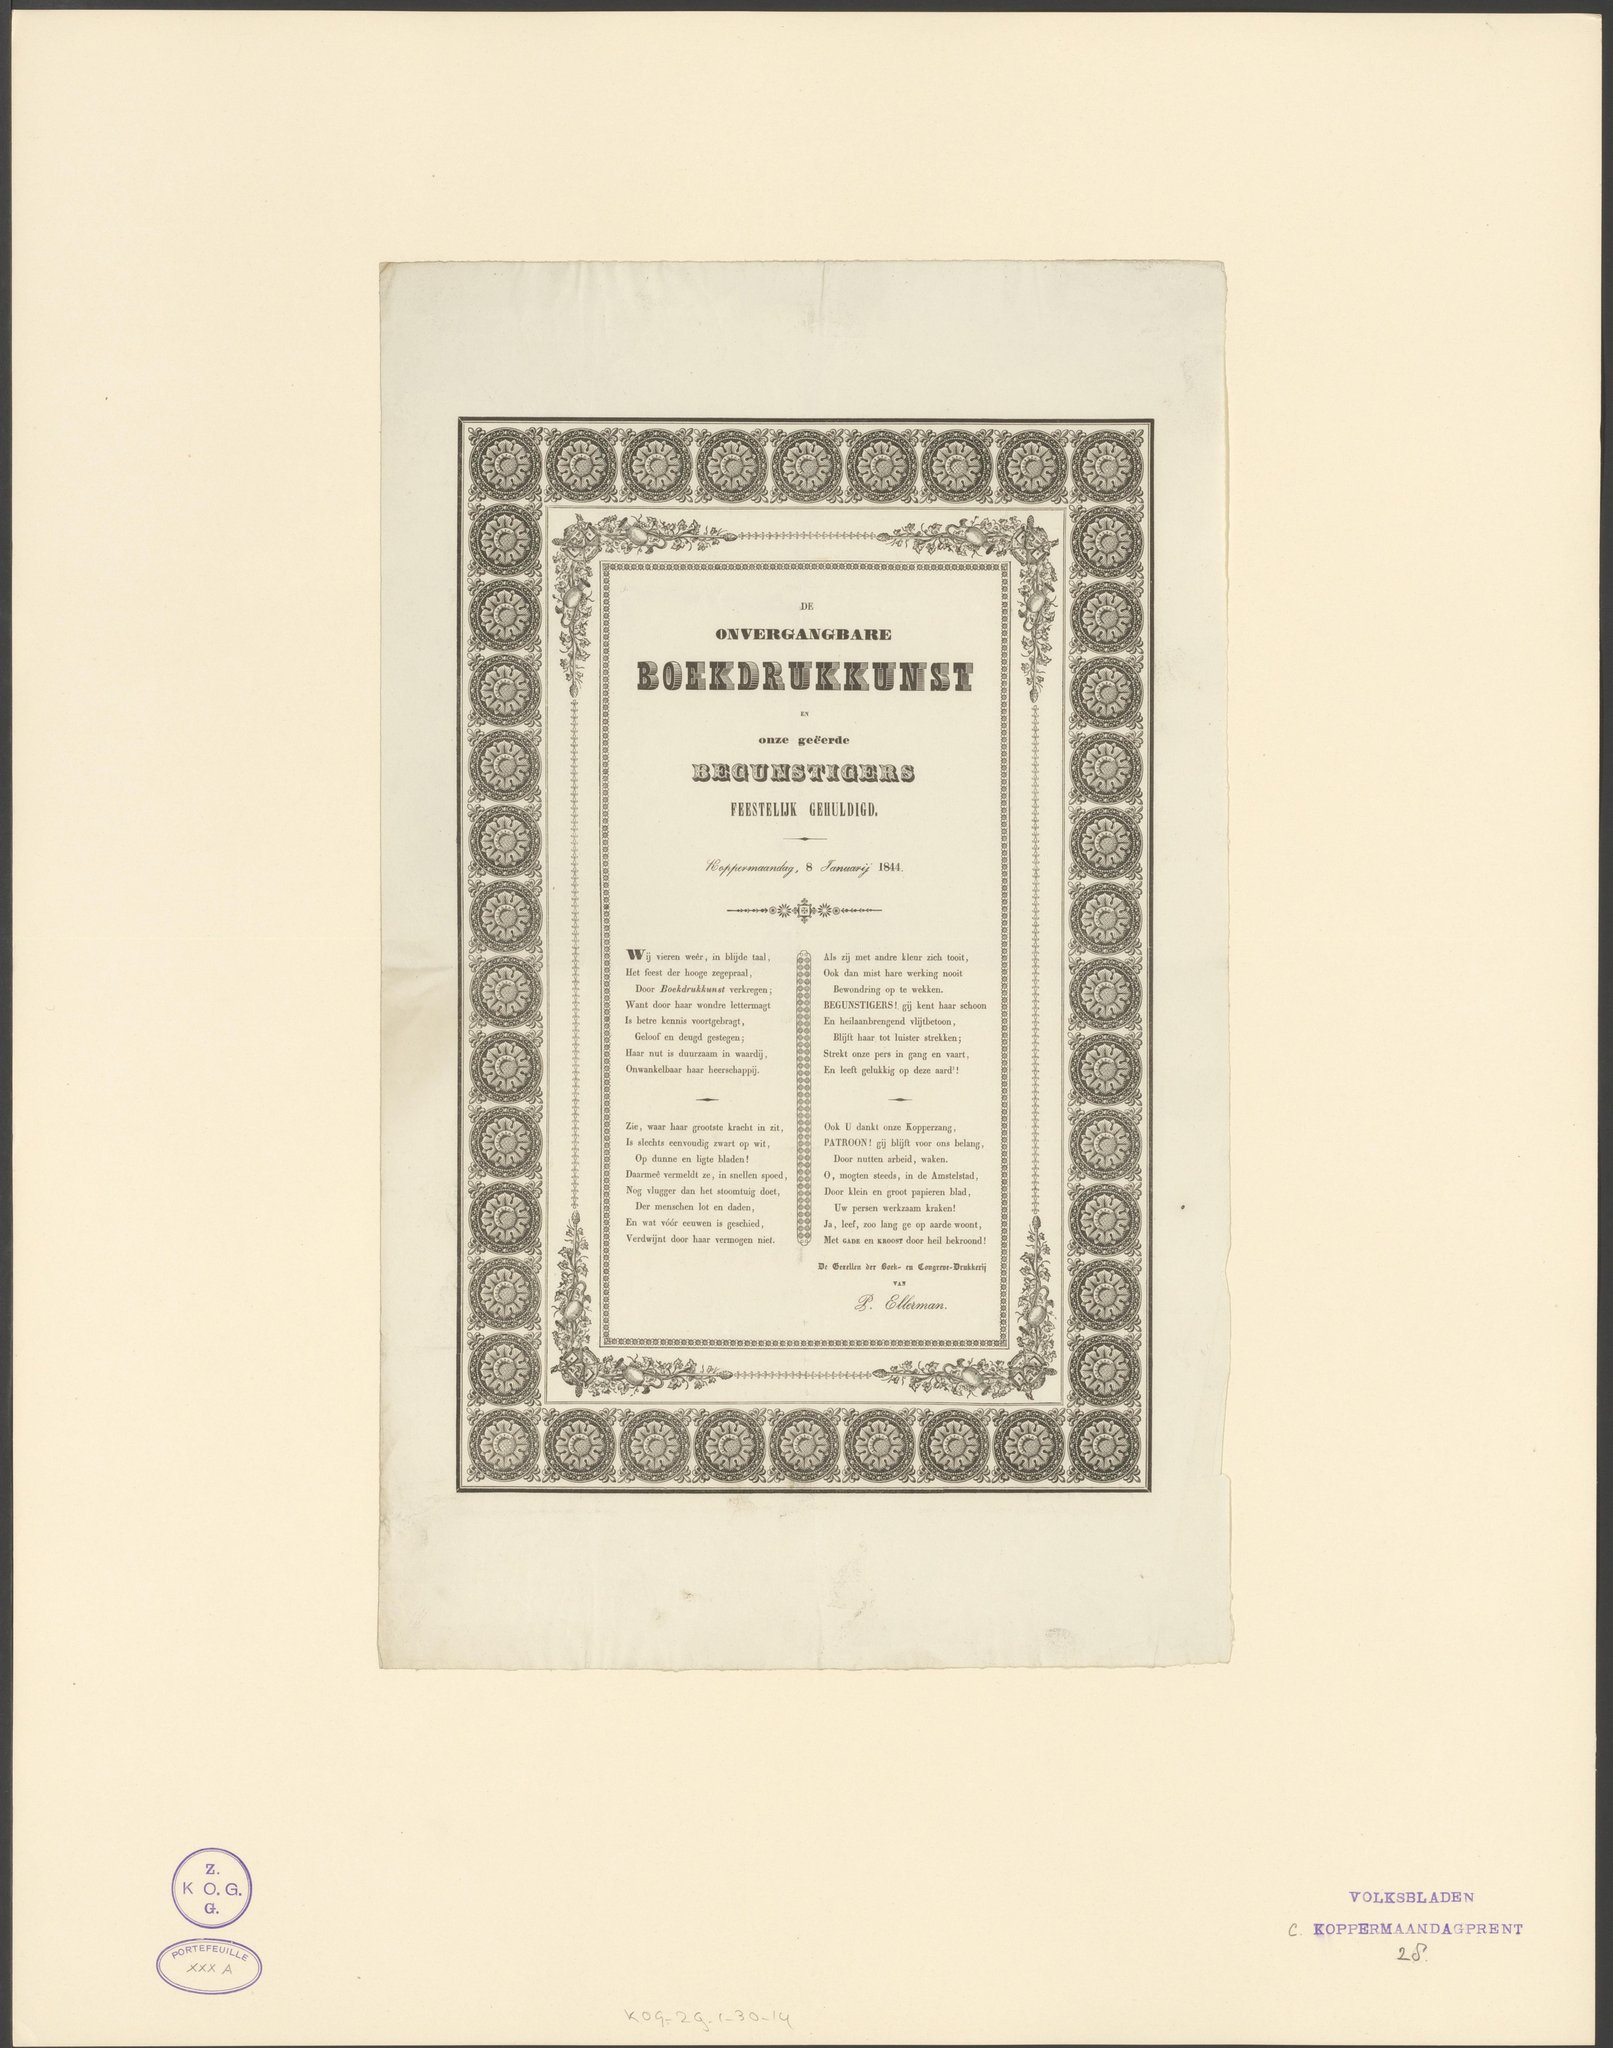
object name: koppermaandagprent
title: De onvergangbare Boekdrukkunst en onze geëerde begunstigers (...)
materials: paper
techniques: letterpress printing, printing block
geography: amsterdam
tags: 'blue monday'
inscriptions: collector's mark: Lugt 1641, stamp, stamp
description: Koppermaandagprent door de gezellen van de boekdrukkerij van J. Ellerman te Amsterdam, ter gelegenheid van Koppermaandag 8 januari 1844. In het midden een vers in twee kolommen namens de gezellen. Onderwerpsrubrieken binnen de Atlas Zeden en Gewoonten: Zeden en Gewoonten in engeren zin. Volksleven. Volksbladen. Koppermaandagwenschen.